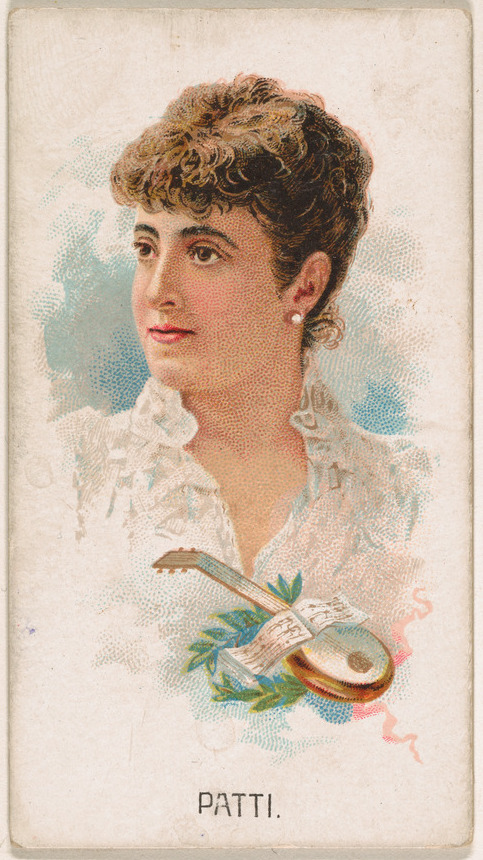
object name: print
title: Patti, from Leaders series (N222) issued by Kinney Bros.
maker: kinney brothers tobacco company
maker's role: publisher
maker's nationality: american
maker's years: 1869-2011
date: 1888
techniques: color lithograph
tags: women,lutes